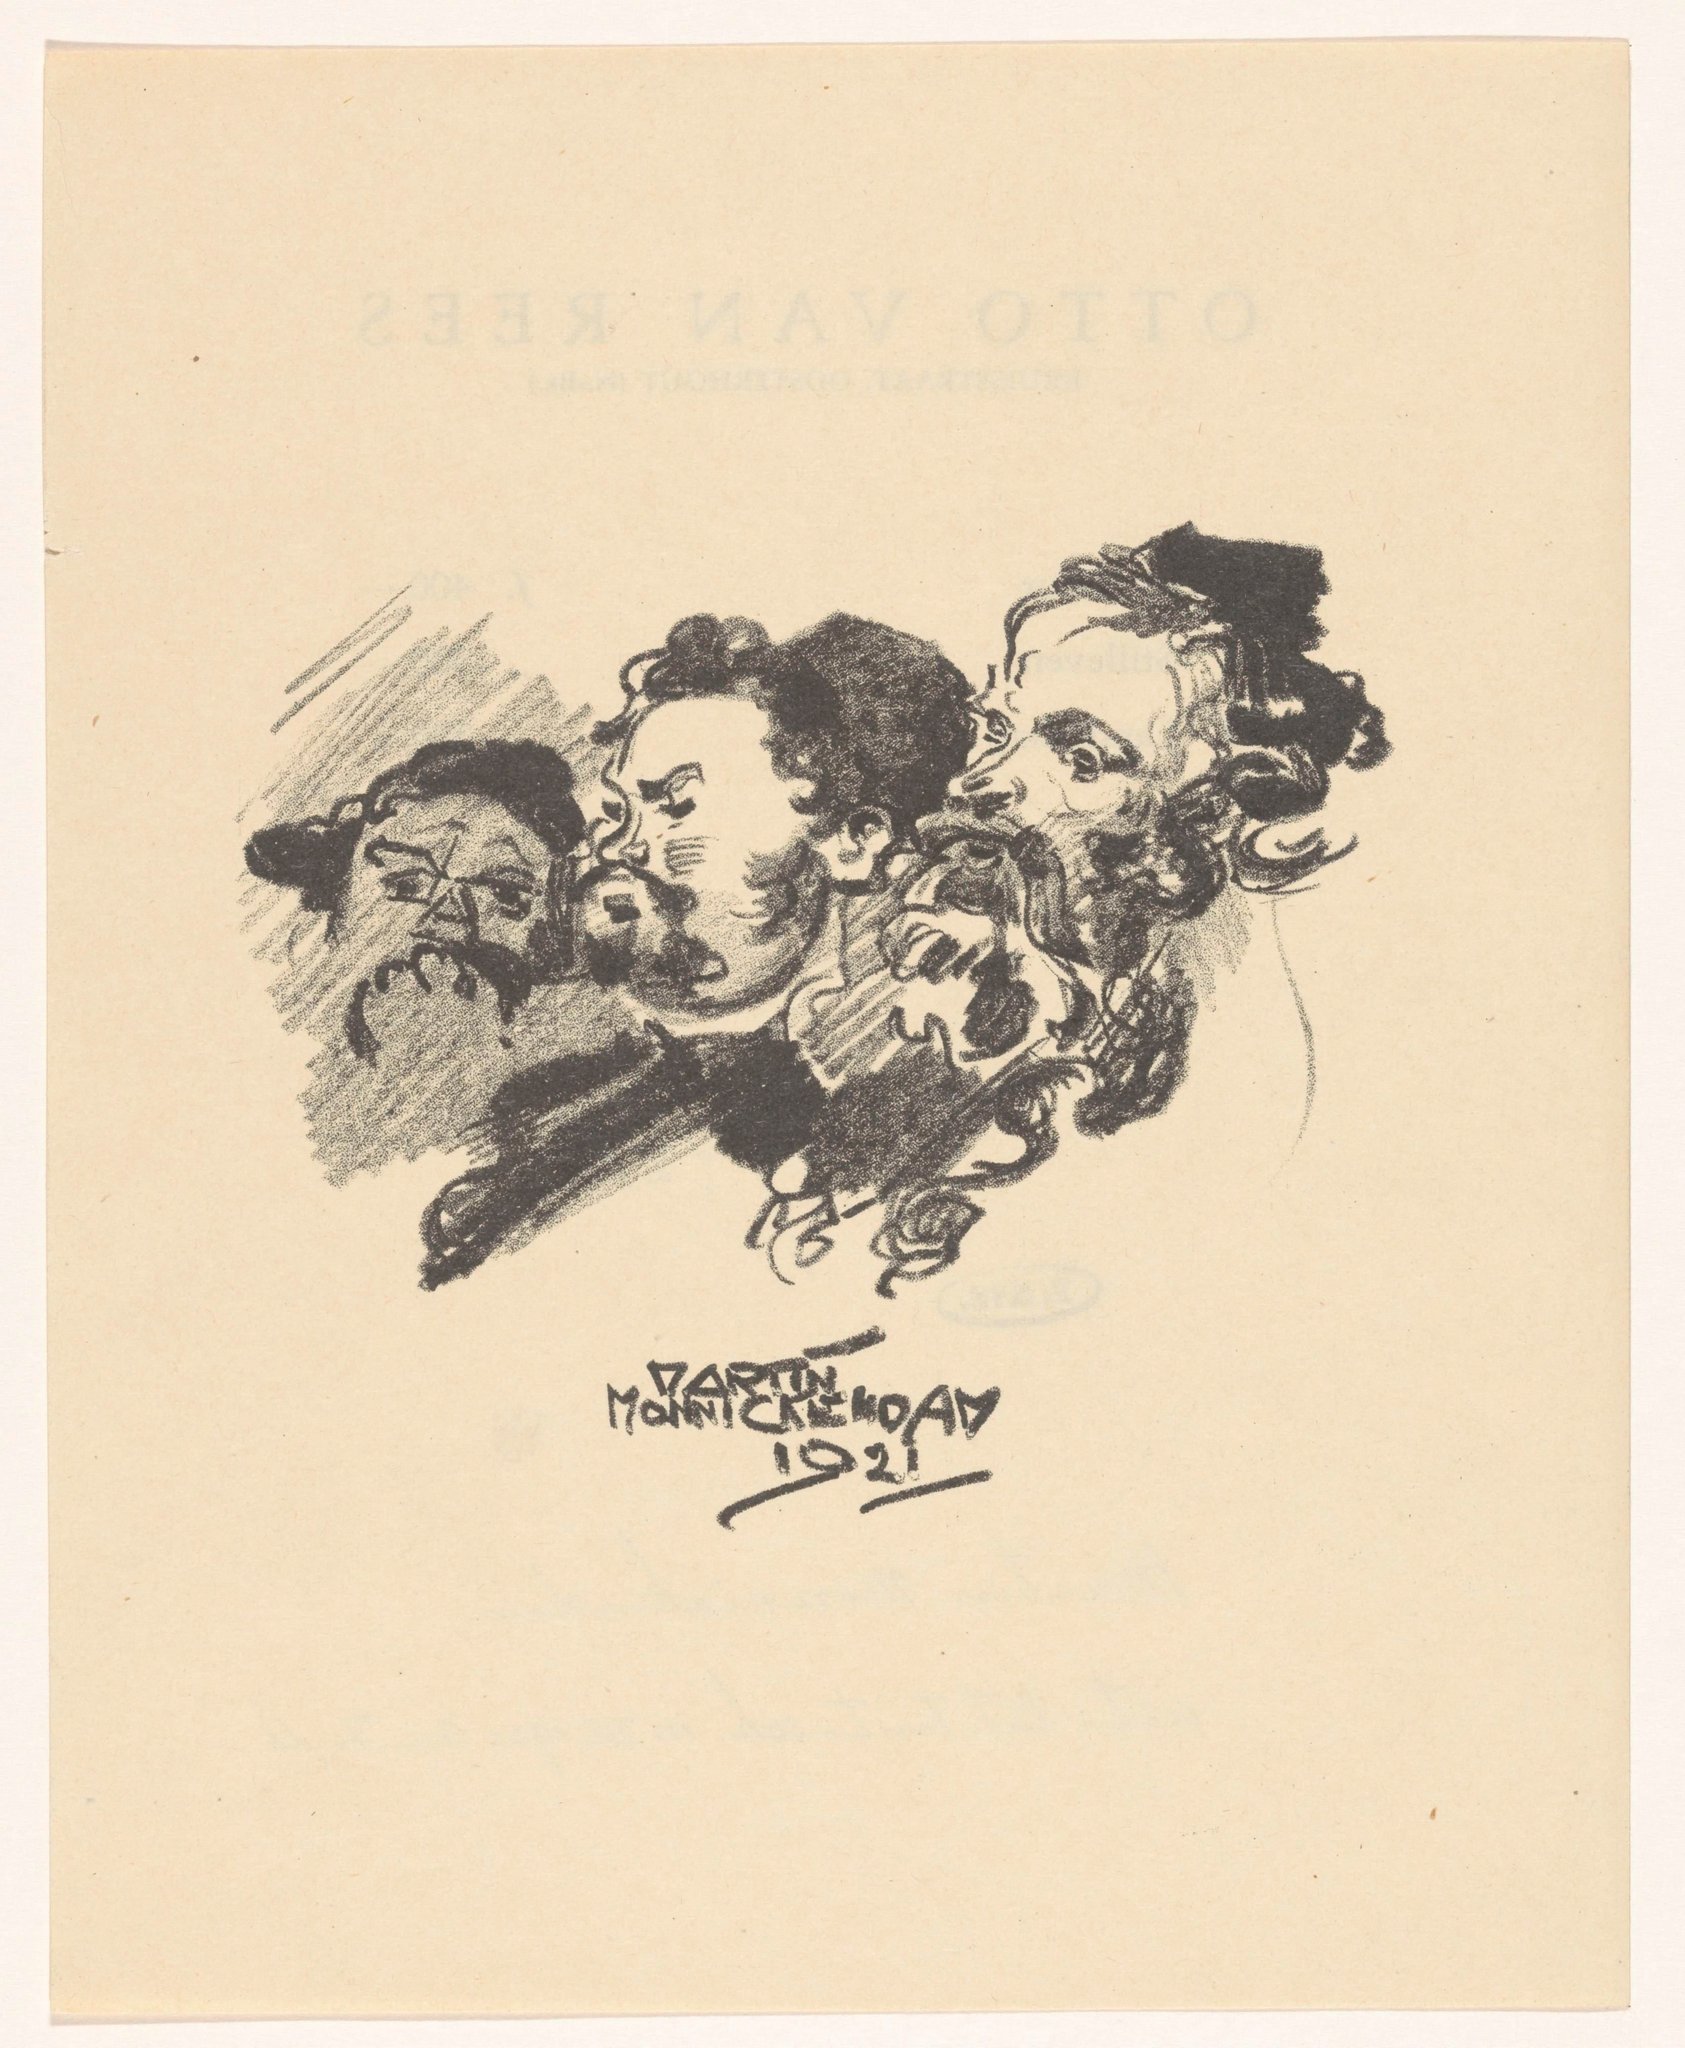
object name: reproduction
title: Reproductie van: Studie van drie mannenhoofden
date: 1921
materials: paper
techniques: printing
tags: adult man, beard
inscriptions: collector's mark: Lugt 2228, annotation: ‘uit: Cat. Tent. sch. 10 III 1921 Amsterdam’, collector's mark: Lugt 2760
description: Bladzijde afkomstig uit: Catalogus van schilderijen en teekeningen. Tentoongesteld in het Stedelijk Museum Amsterdam. Amsterdam: Hollandsche Kunstenaarskring, 1921.